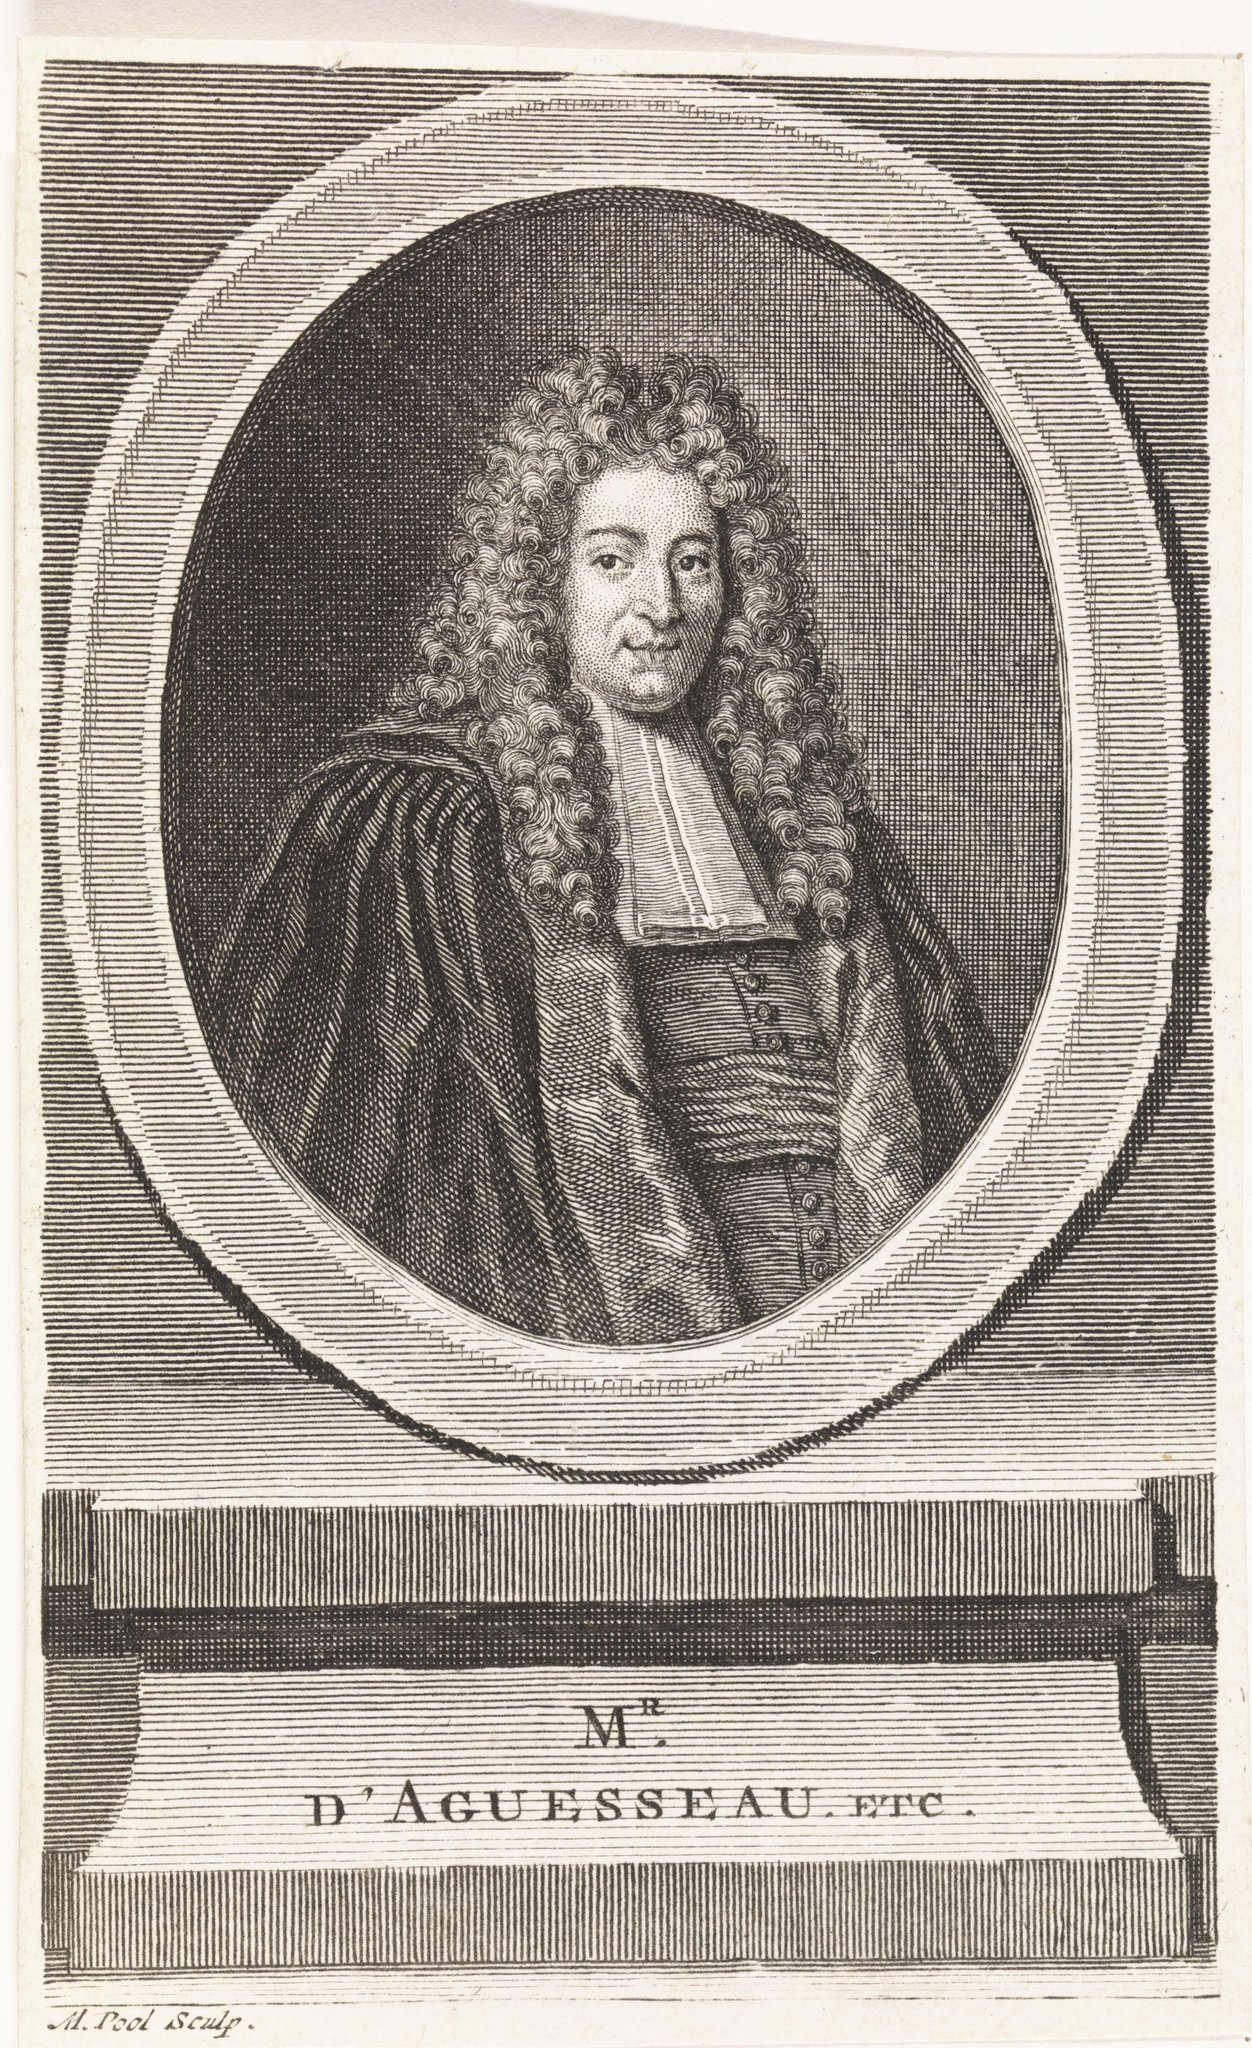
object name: print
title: Portret van Henri François d'Aguesseau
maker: matthijs pool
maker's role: print maker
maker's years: 1676-1740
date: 1686-1727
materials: paper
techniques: etching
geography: amsterdam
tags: henri françois d' aguesseau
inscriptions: collector's mark: Lugt 2228